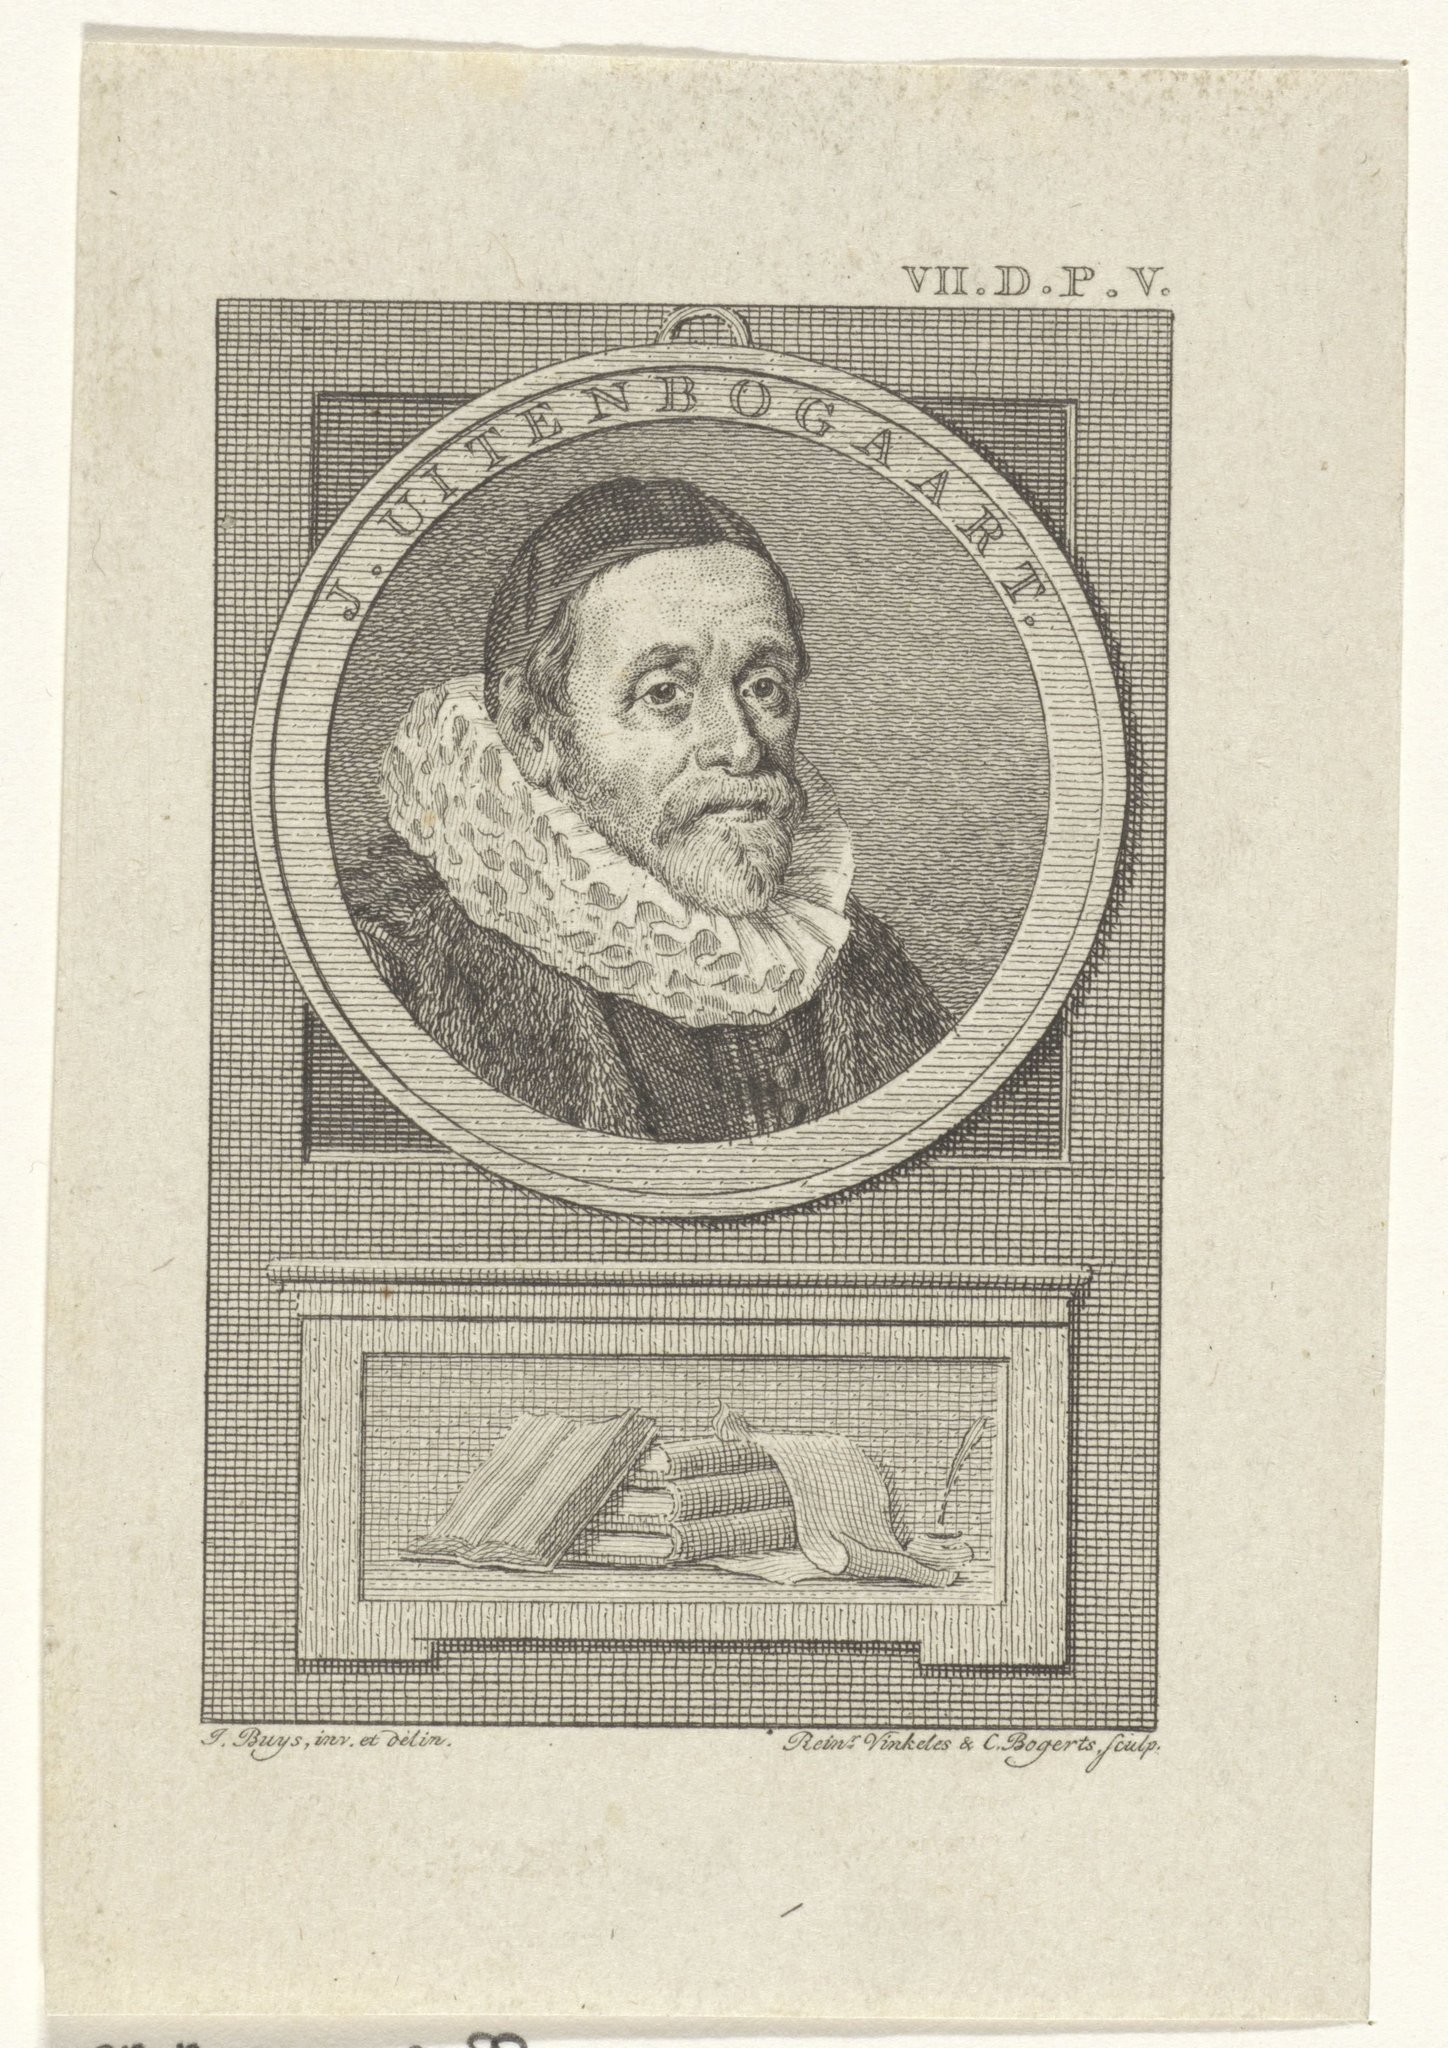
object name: print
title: Portret van Johannes Wtenbogaert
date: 1783-1795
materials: paper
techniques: engraving, etching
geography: amsterdam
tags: utrecht, the hague, quill, ink-well, book, paper (writing material)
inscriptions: collector's mark: Lugt 2228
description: Portret van Johannes Wtenbogaert, raadsman van Van Oldebarnevelt en hofpredikant van stadhouder prins Maurits. Onder het portret boeken, een vel papier en een inkpot met schrijfveer. Rechtsboven: VII.D.P.V.